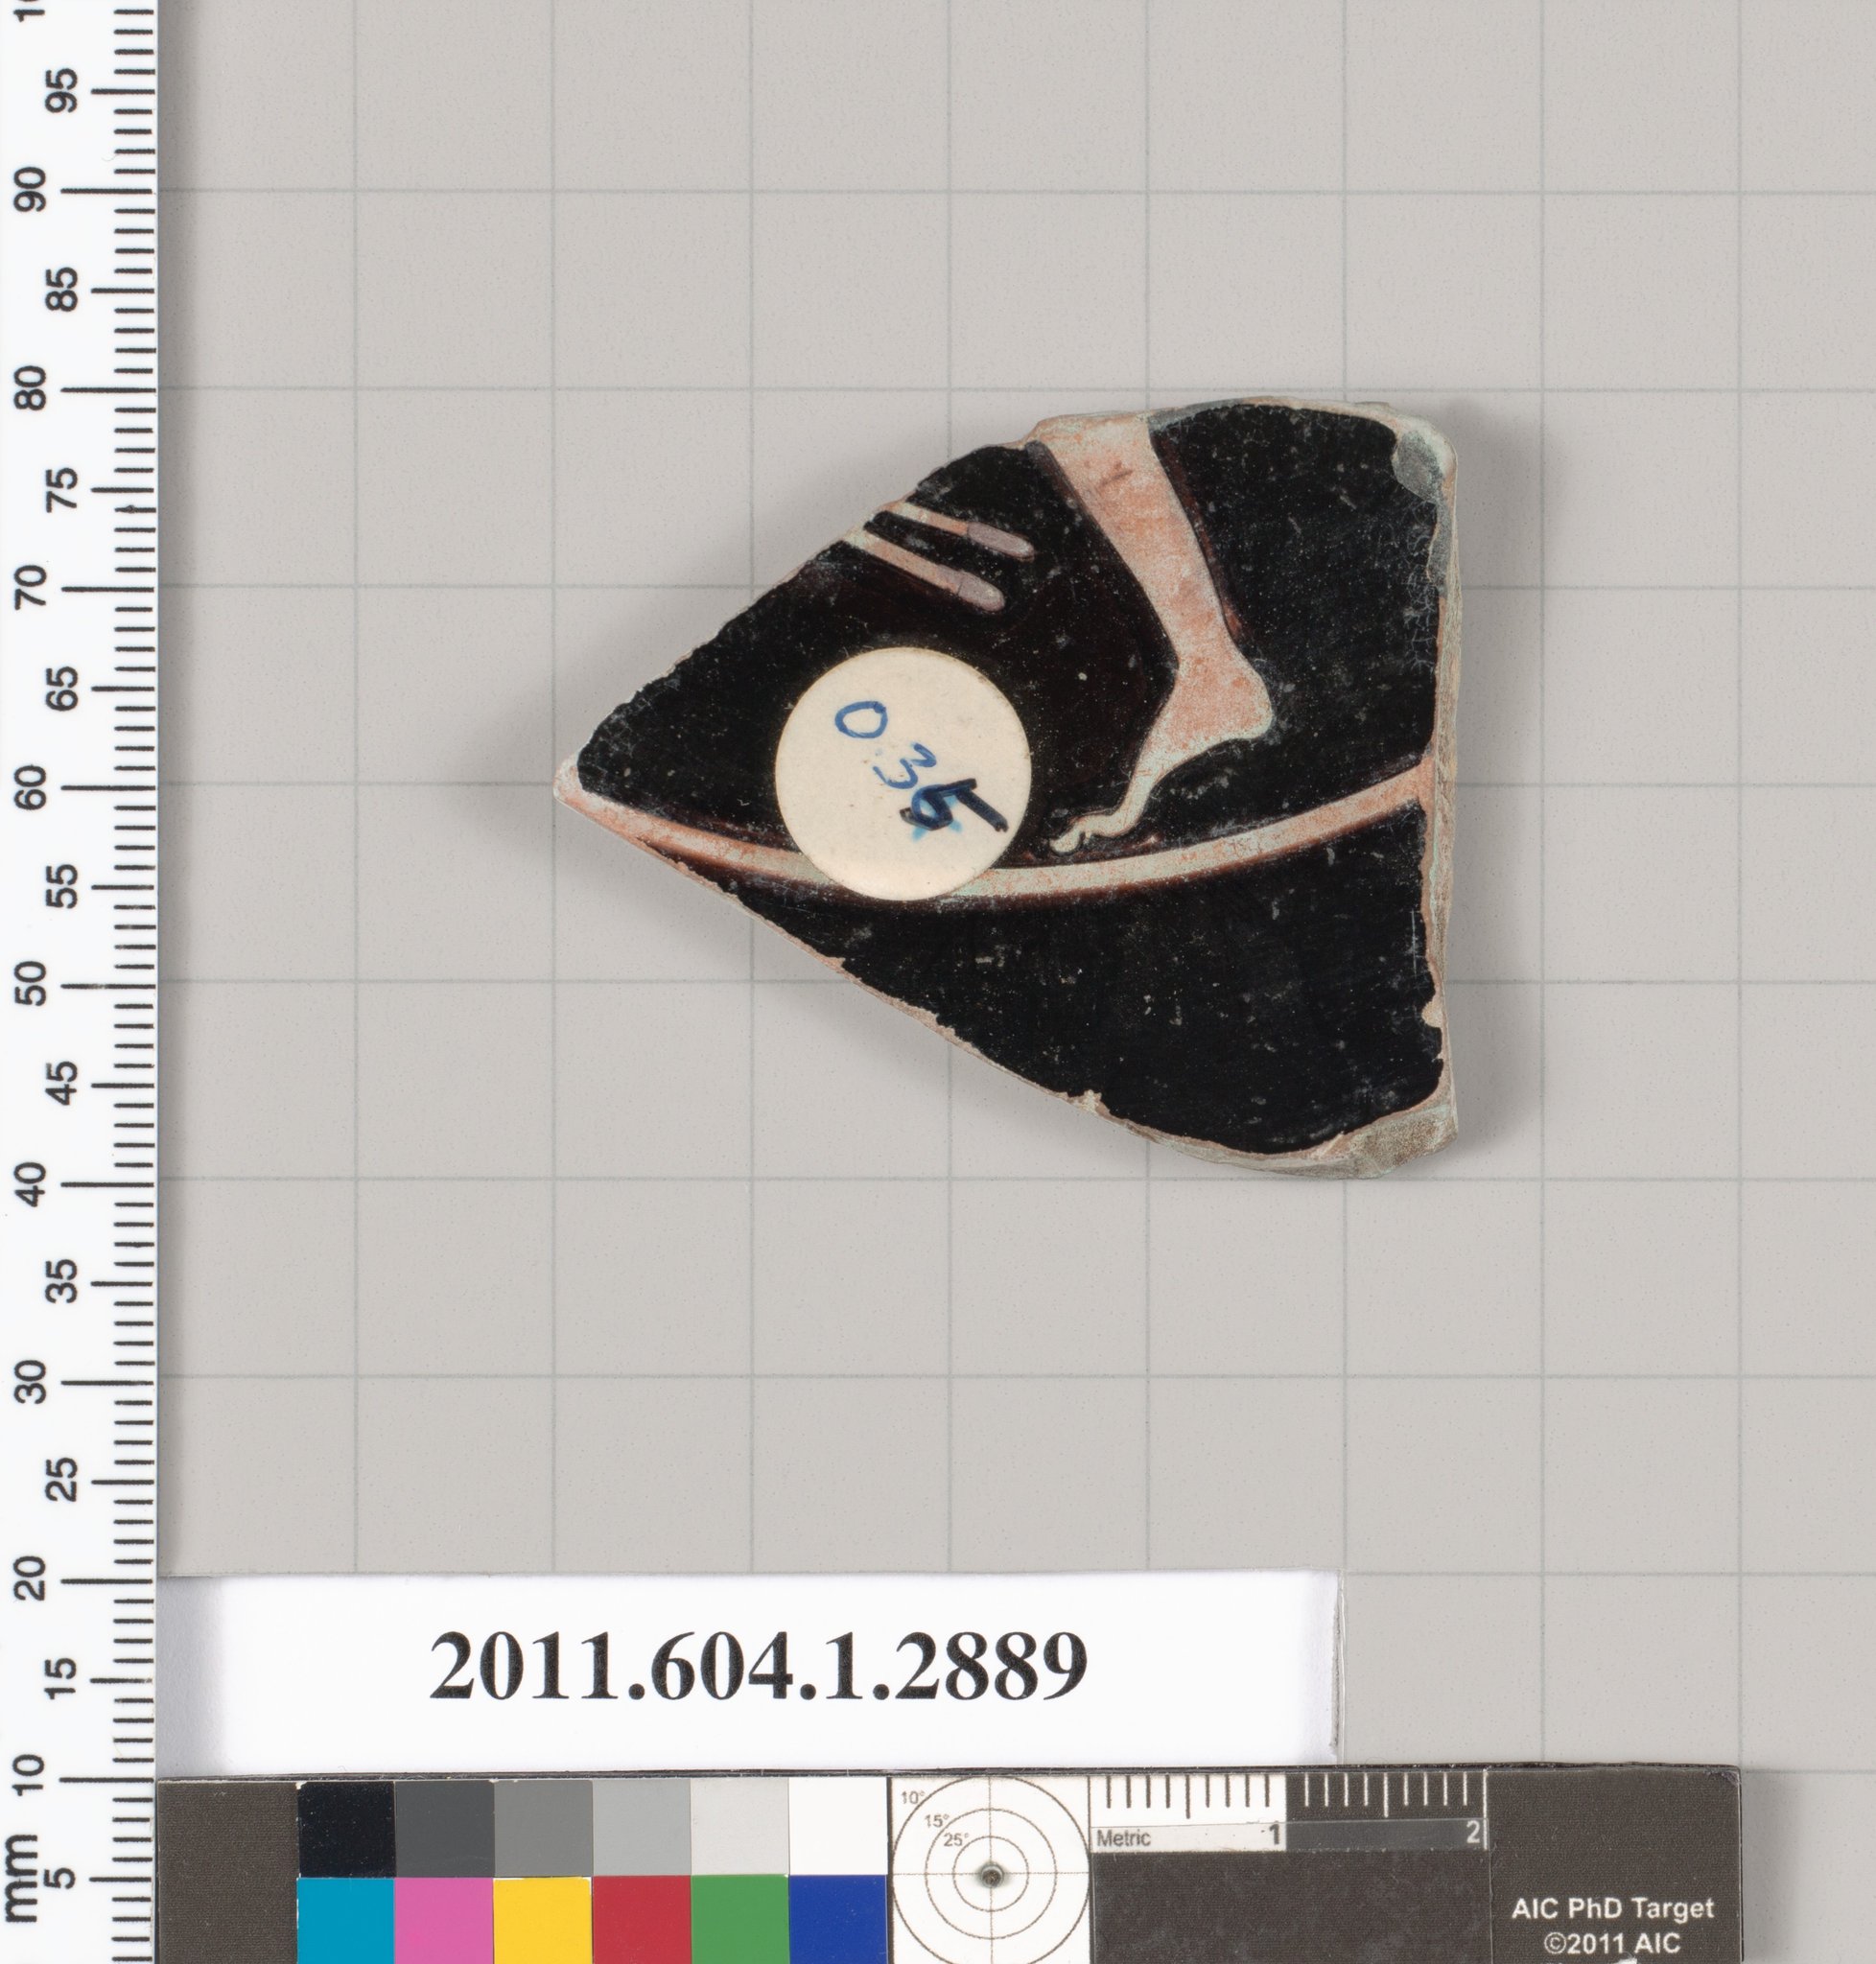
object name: kylix fragment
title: Terracotta fragment of a kylix (drinking cup)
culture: greek, attic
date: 520-500 BCE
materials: terracotta